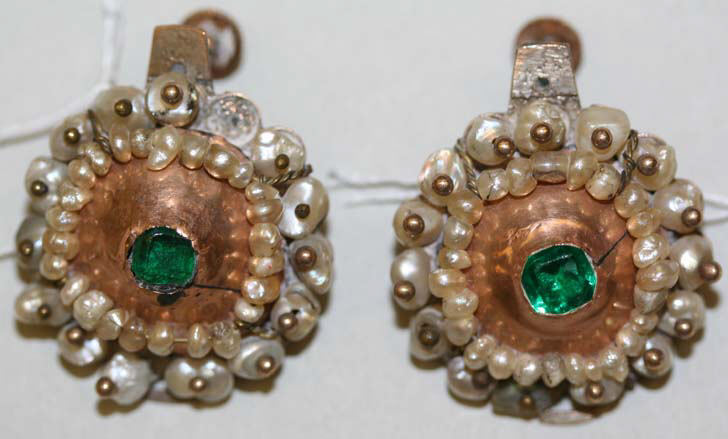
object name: earring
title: Earrings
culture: italian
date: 1801-1833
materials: gold